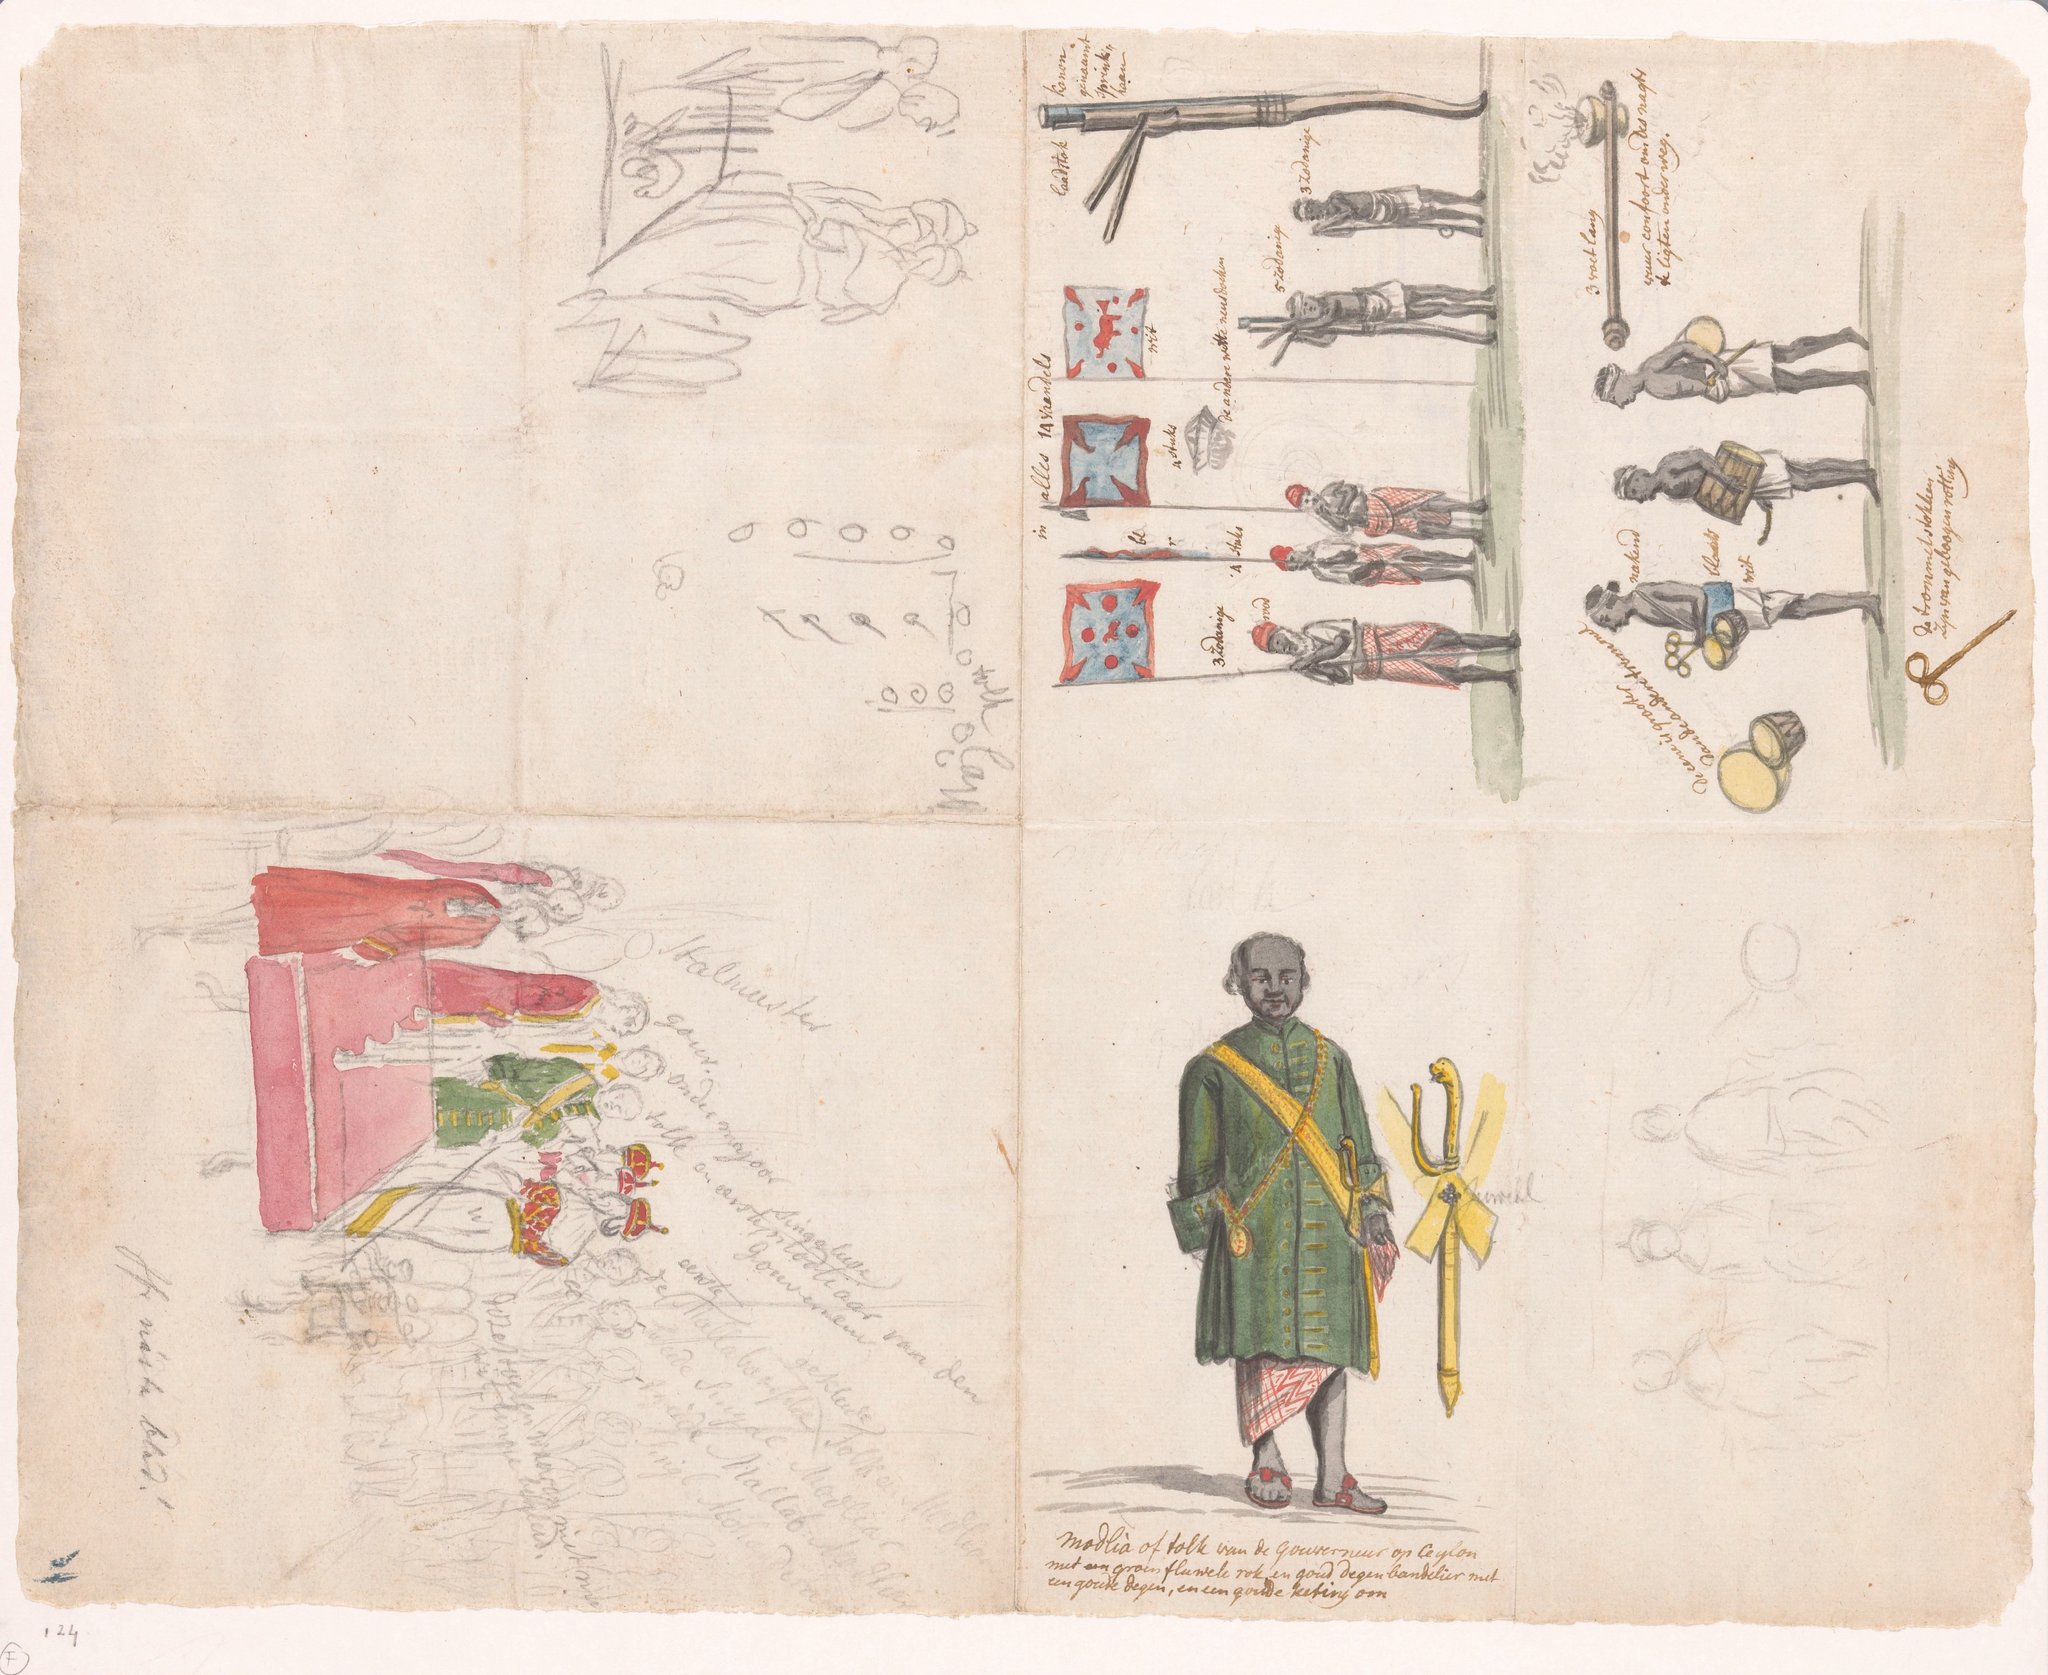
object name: drawing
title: Ontvangst van gezanten van de koning Kandy, 1785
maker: jan brandes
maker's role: draughtsman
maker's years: 1743-1808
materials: paper, pencil, watercolor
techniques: brush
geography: colombo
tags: family of a ruler, and court, asiatic races and peoples (srilankans)